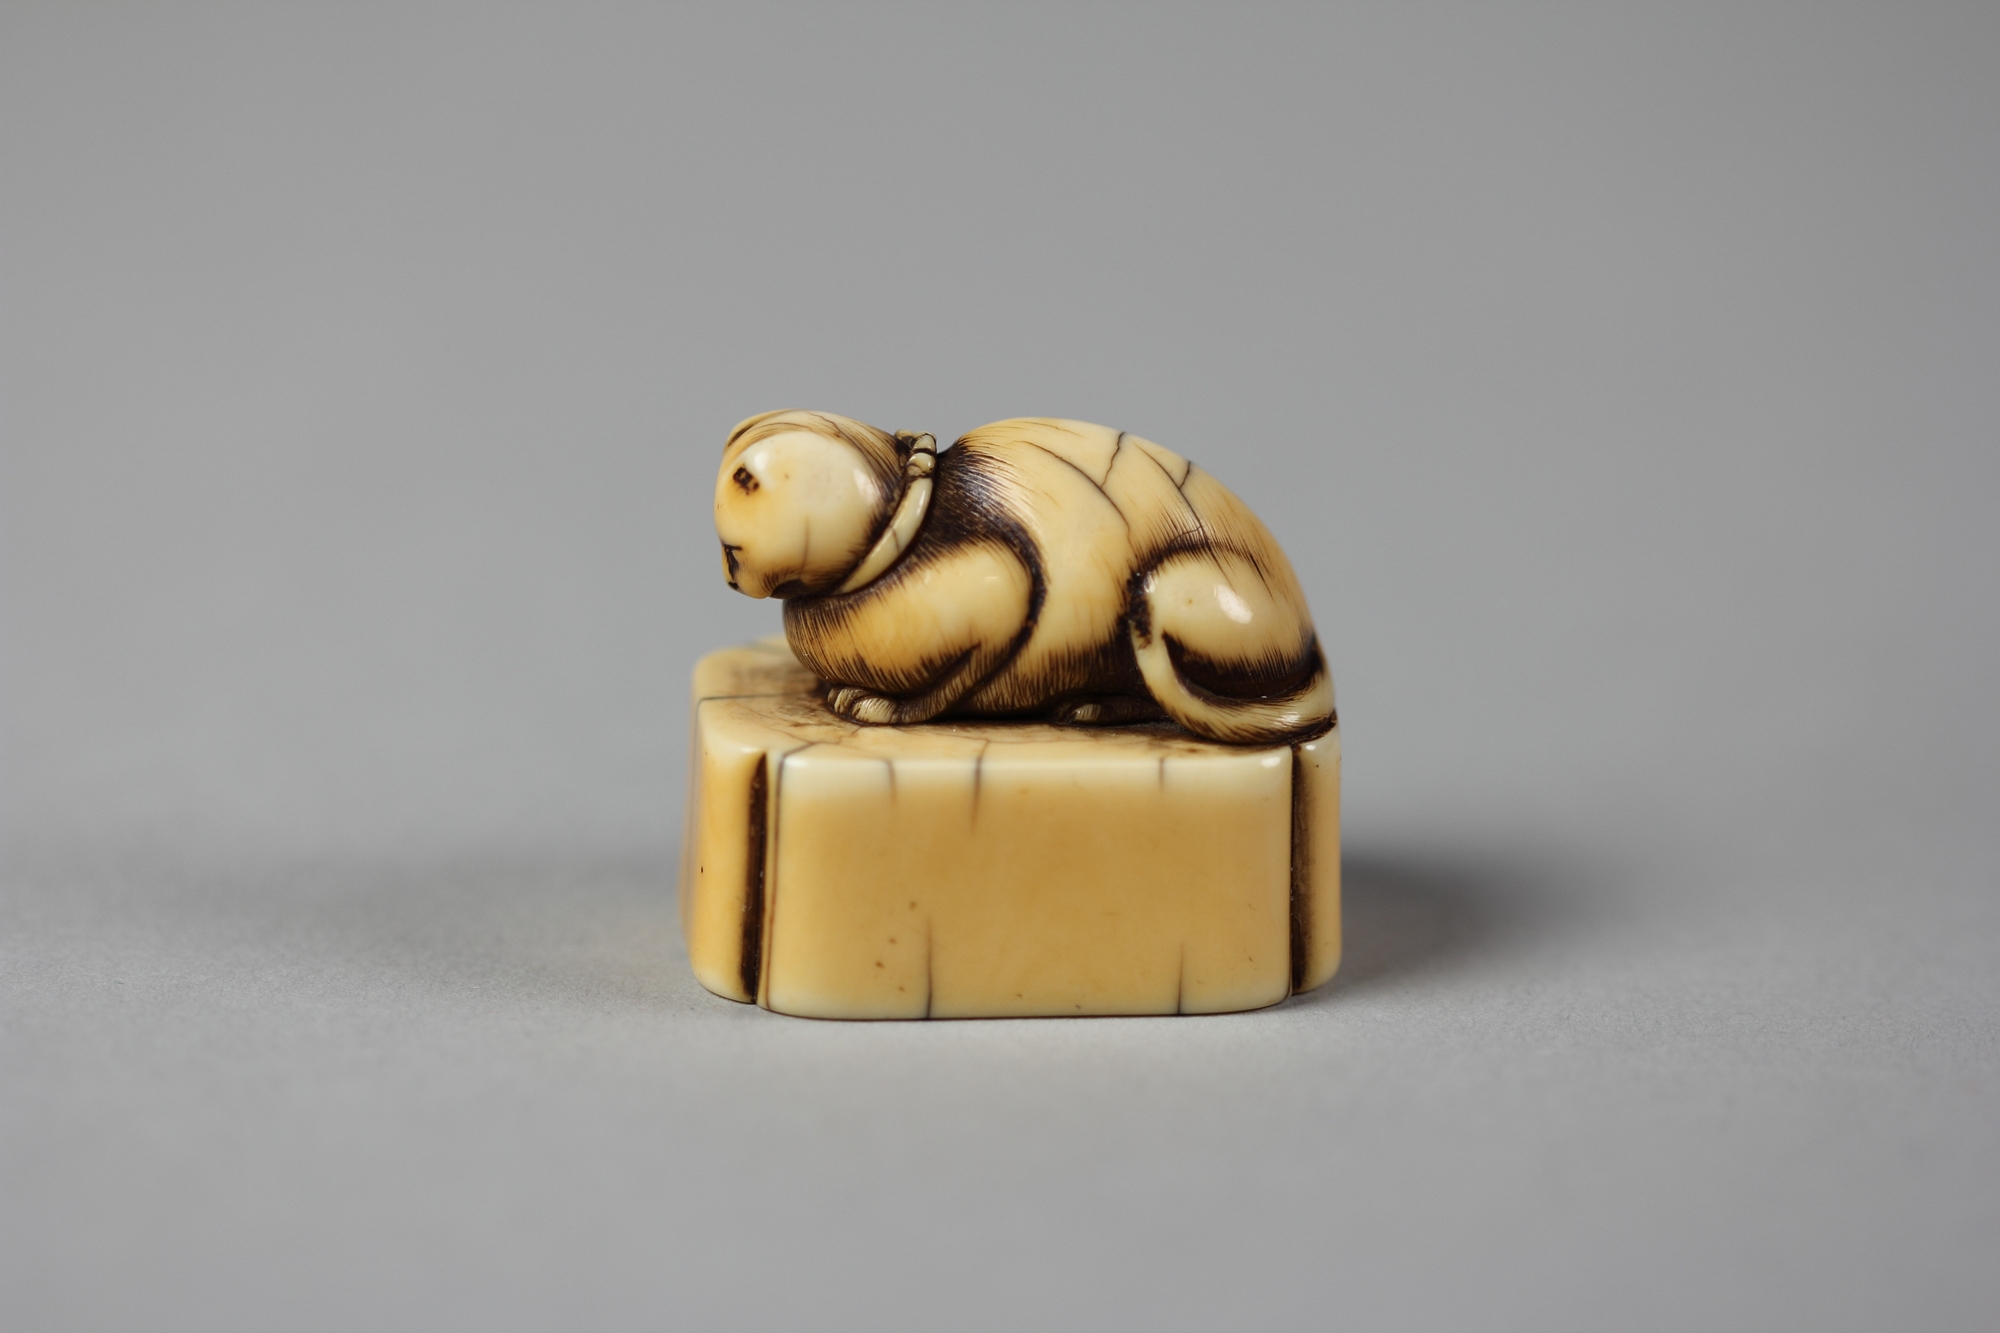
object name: netsuke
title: Netsuke of Cat on a Seal-Shaped Base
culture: japanese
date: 1801-1900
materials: ivory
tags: cats